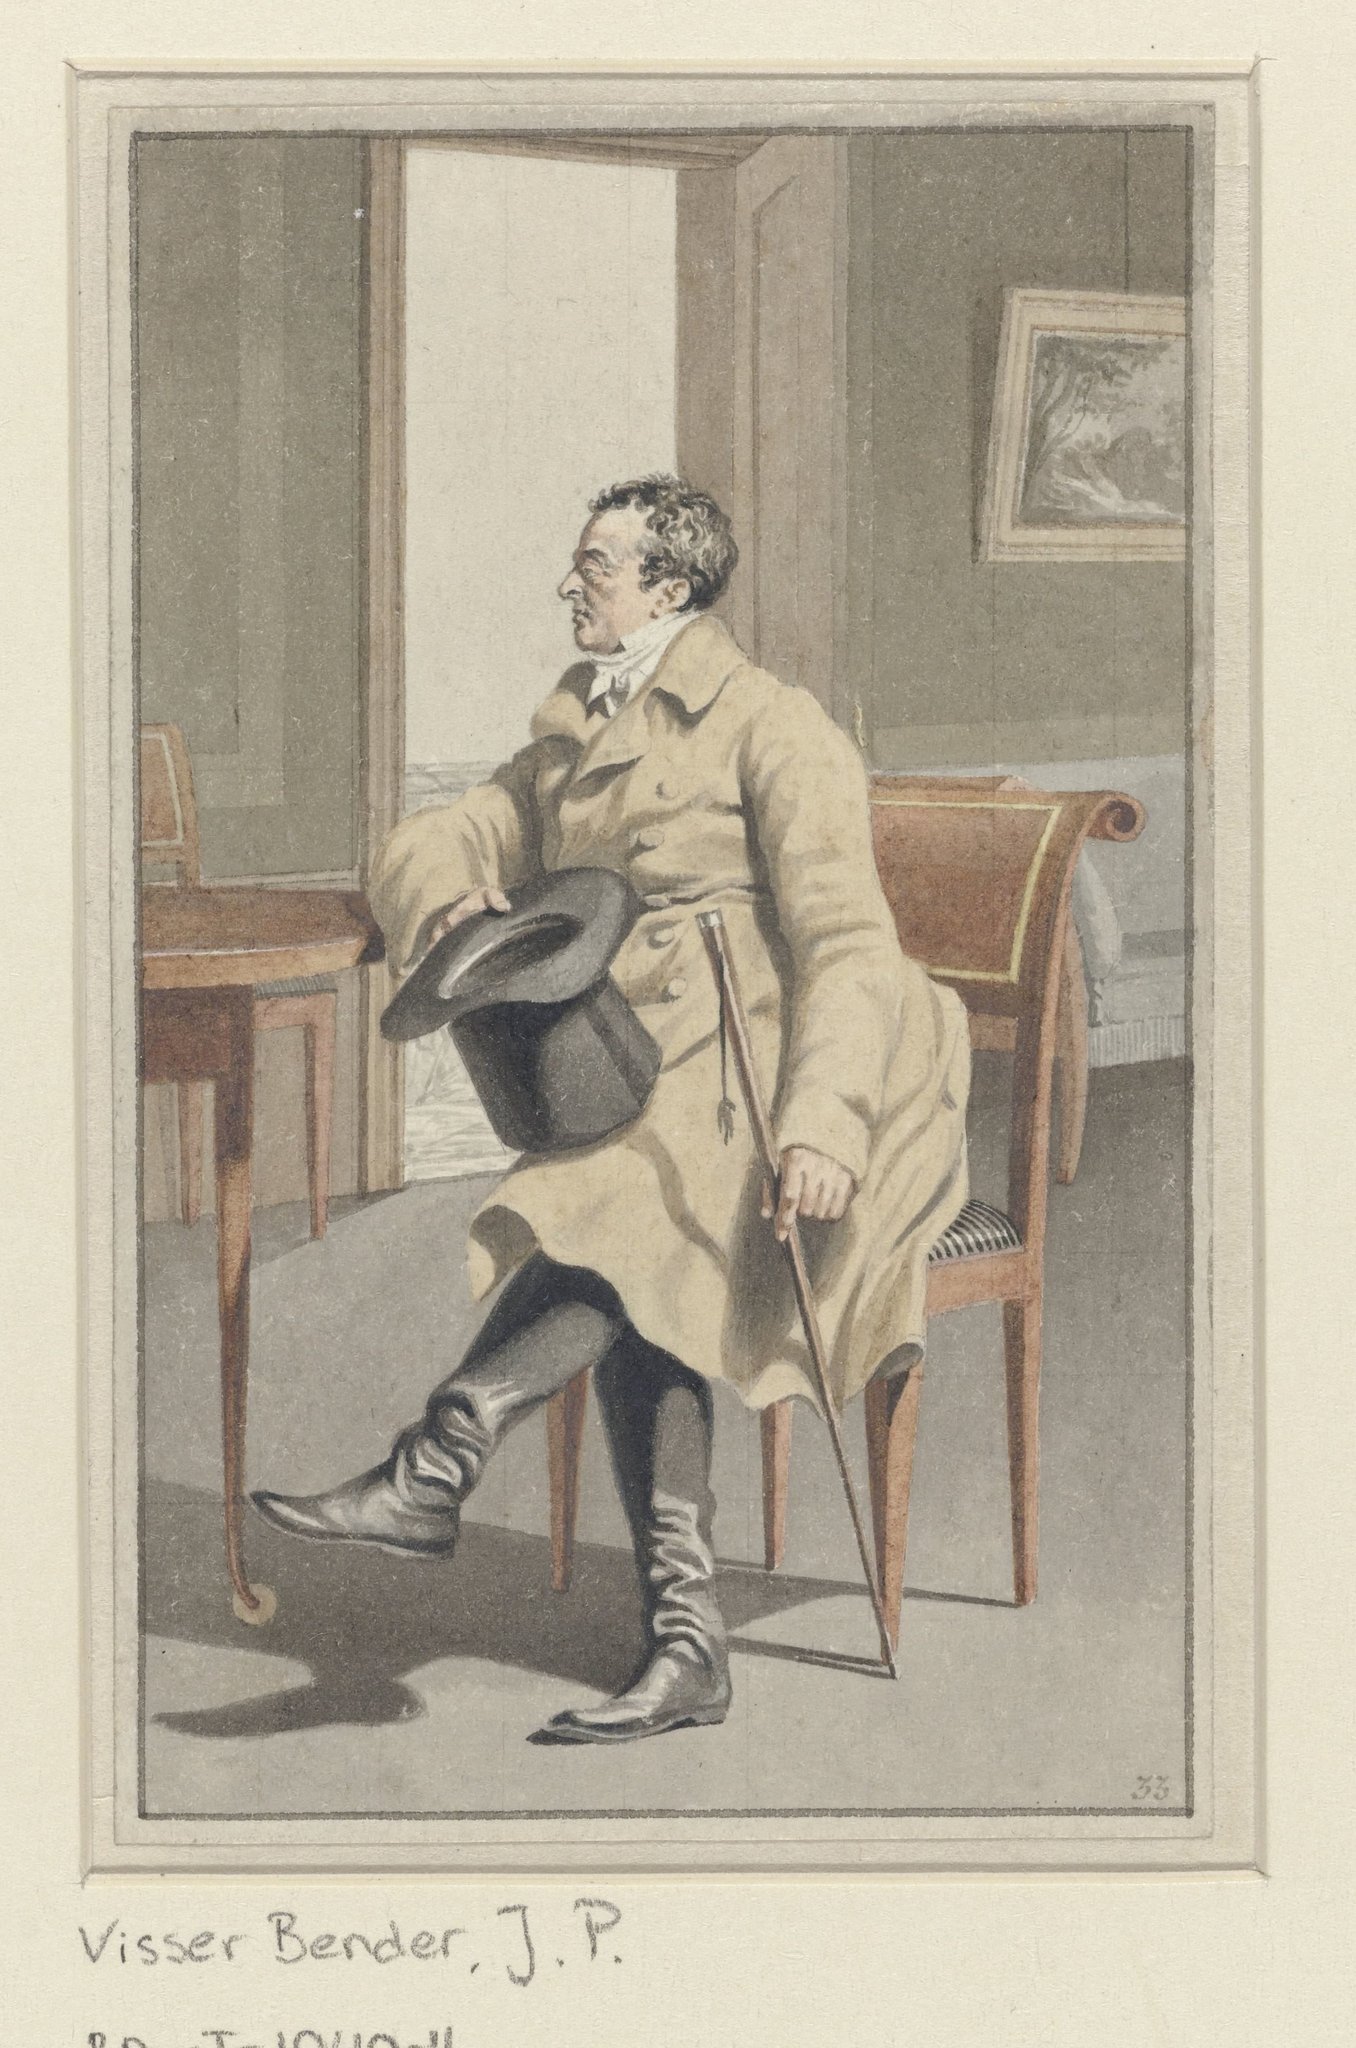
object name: drawing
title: Portret van Pieter Bzn Barbiers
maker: joannes pieter visser bender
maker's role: draughtsman, print maker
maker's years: 1785-1813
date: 1795-1813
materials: paper, watercolor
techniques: brush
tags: amsterdam, pieter pietersz. barbiers, historical persons, portrait, self-portrait of painter, portrait, self-portrait of artist, portrait, self-portrait of draughtsman